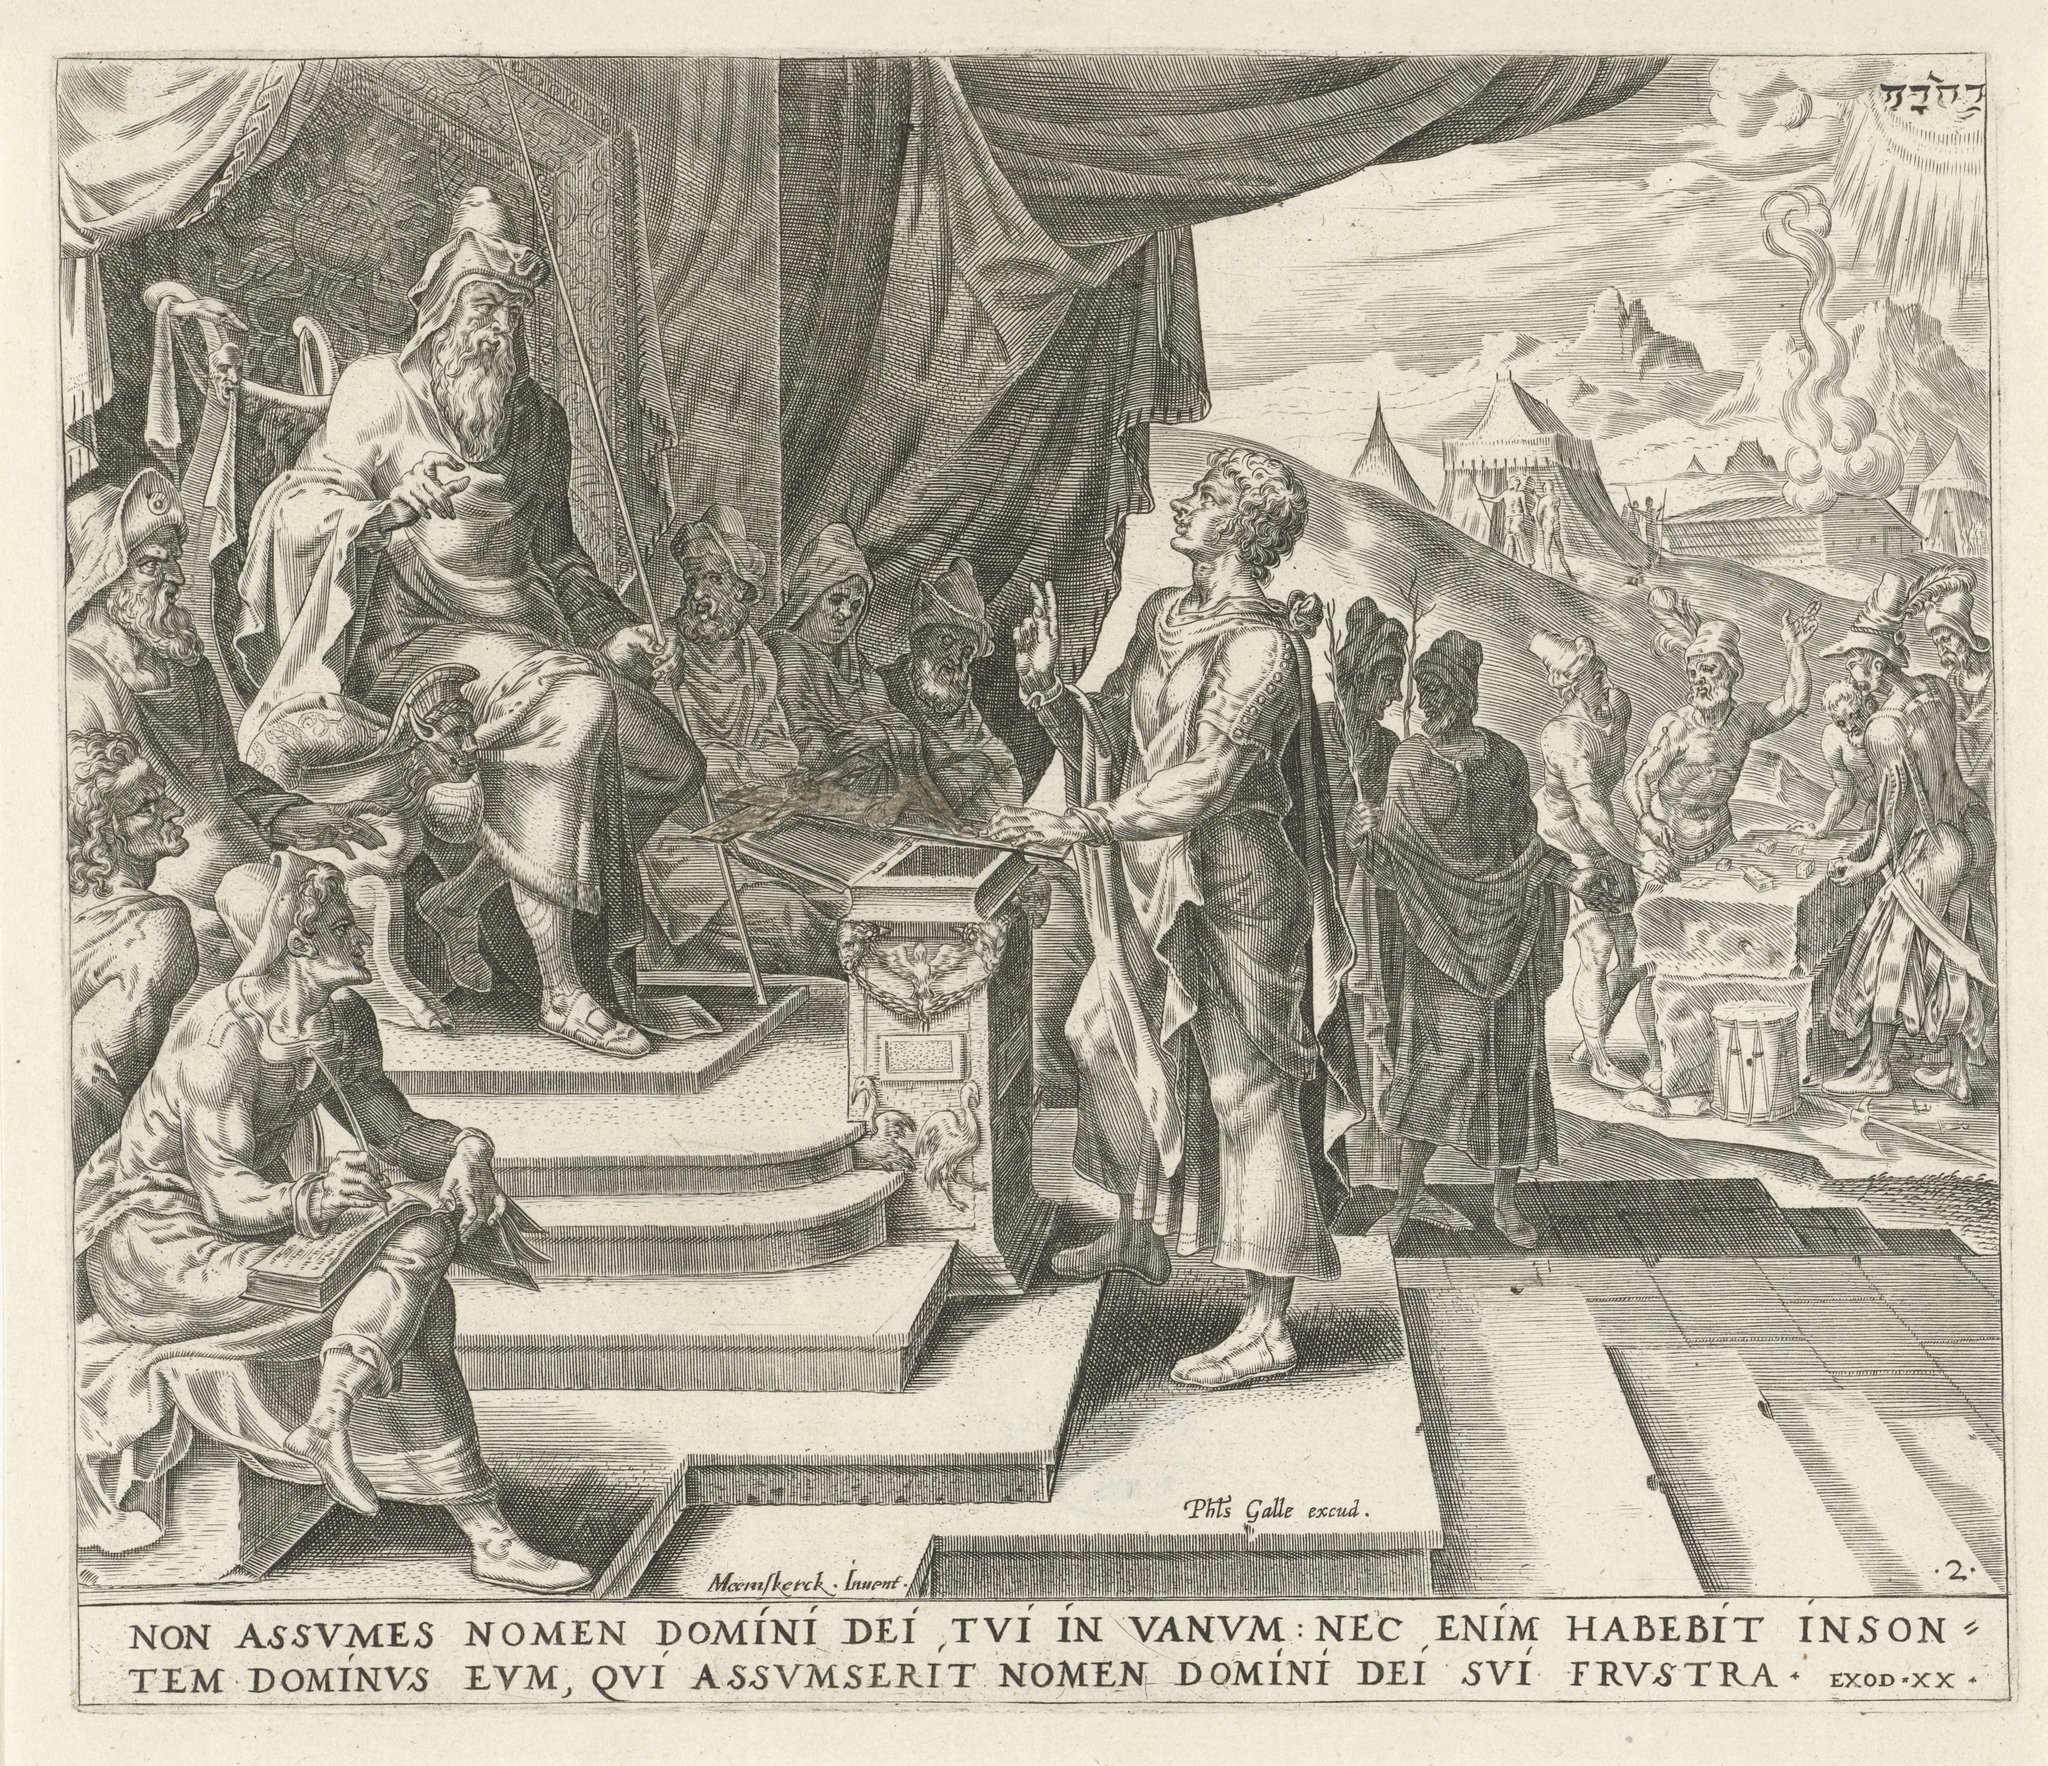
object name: print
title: Gij zult de naam van de Heer uw God niet ijdel gebruiken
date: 1570-1612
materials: paper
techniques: brush, engraving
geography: antwerp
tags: tetragram (in roman or hebrew script) ~ symbol of god the father, 'you shall not take the name of the lord your god in vain' ~ separate representation of the third of the ten commandments, swearing an oath (with two fingers raised)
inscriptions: collector's mark: Lugt 2228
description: Een man voor de rechter zweert bij God, door zijn hand op een opengeslagen Bijbel en een crucifix te leggen. Op de achtergrond spelen mannen kaart en dobbelen, terwijl een de hand heft naar de naam van God aan de hemel. Prent maakt deel uit van een serie over de tien geboden en geeft een overtreding van het tweede gebod weer: Gij zult de naam van de Heer, uw God, niet ijdel gebruiken. Onderaan in de marge een verwijzing naar de Bijbeltekst in het Latijn.